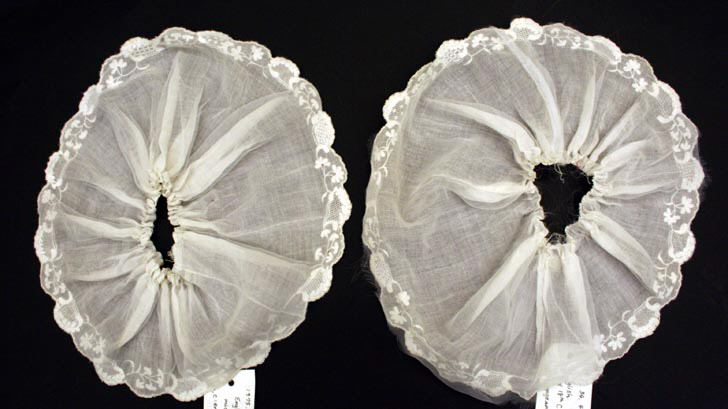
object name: engageantes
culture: british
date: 1734-1766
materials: cotton